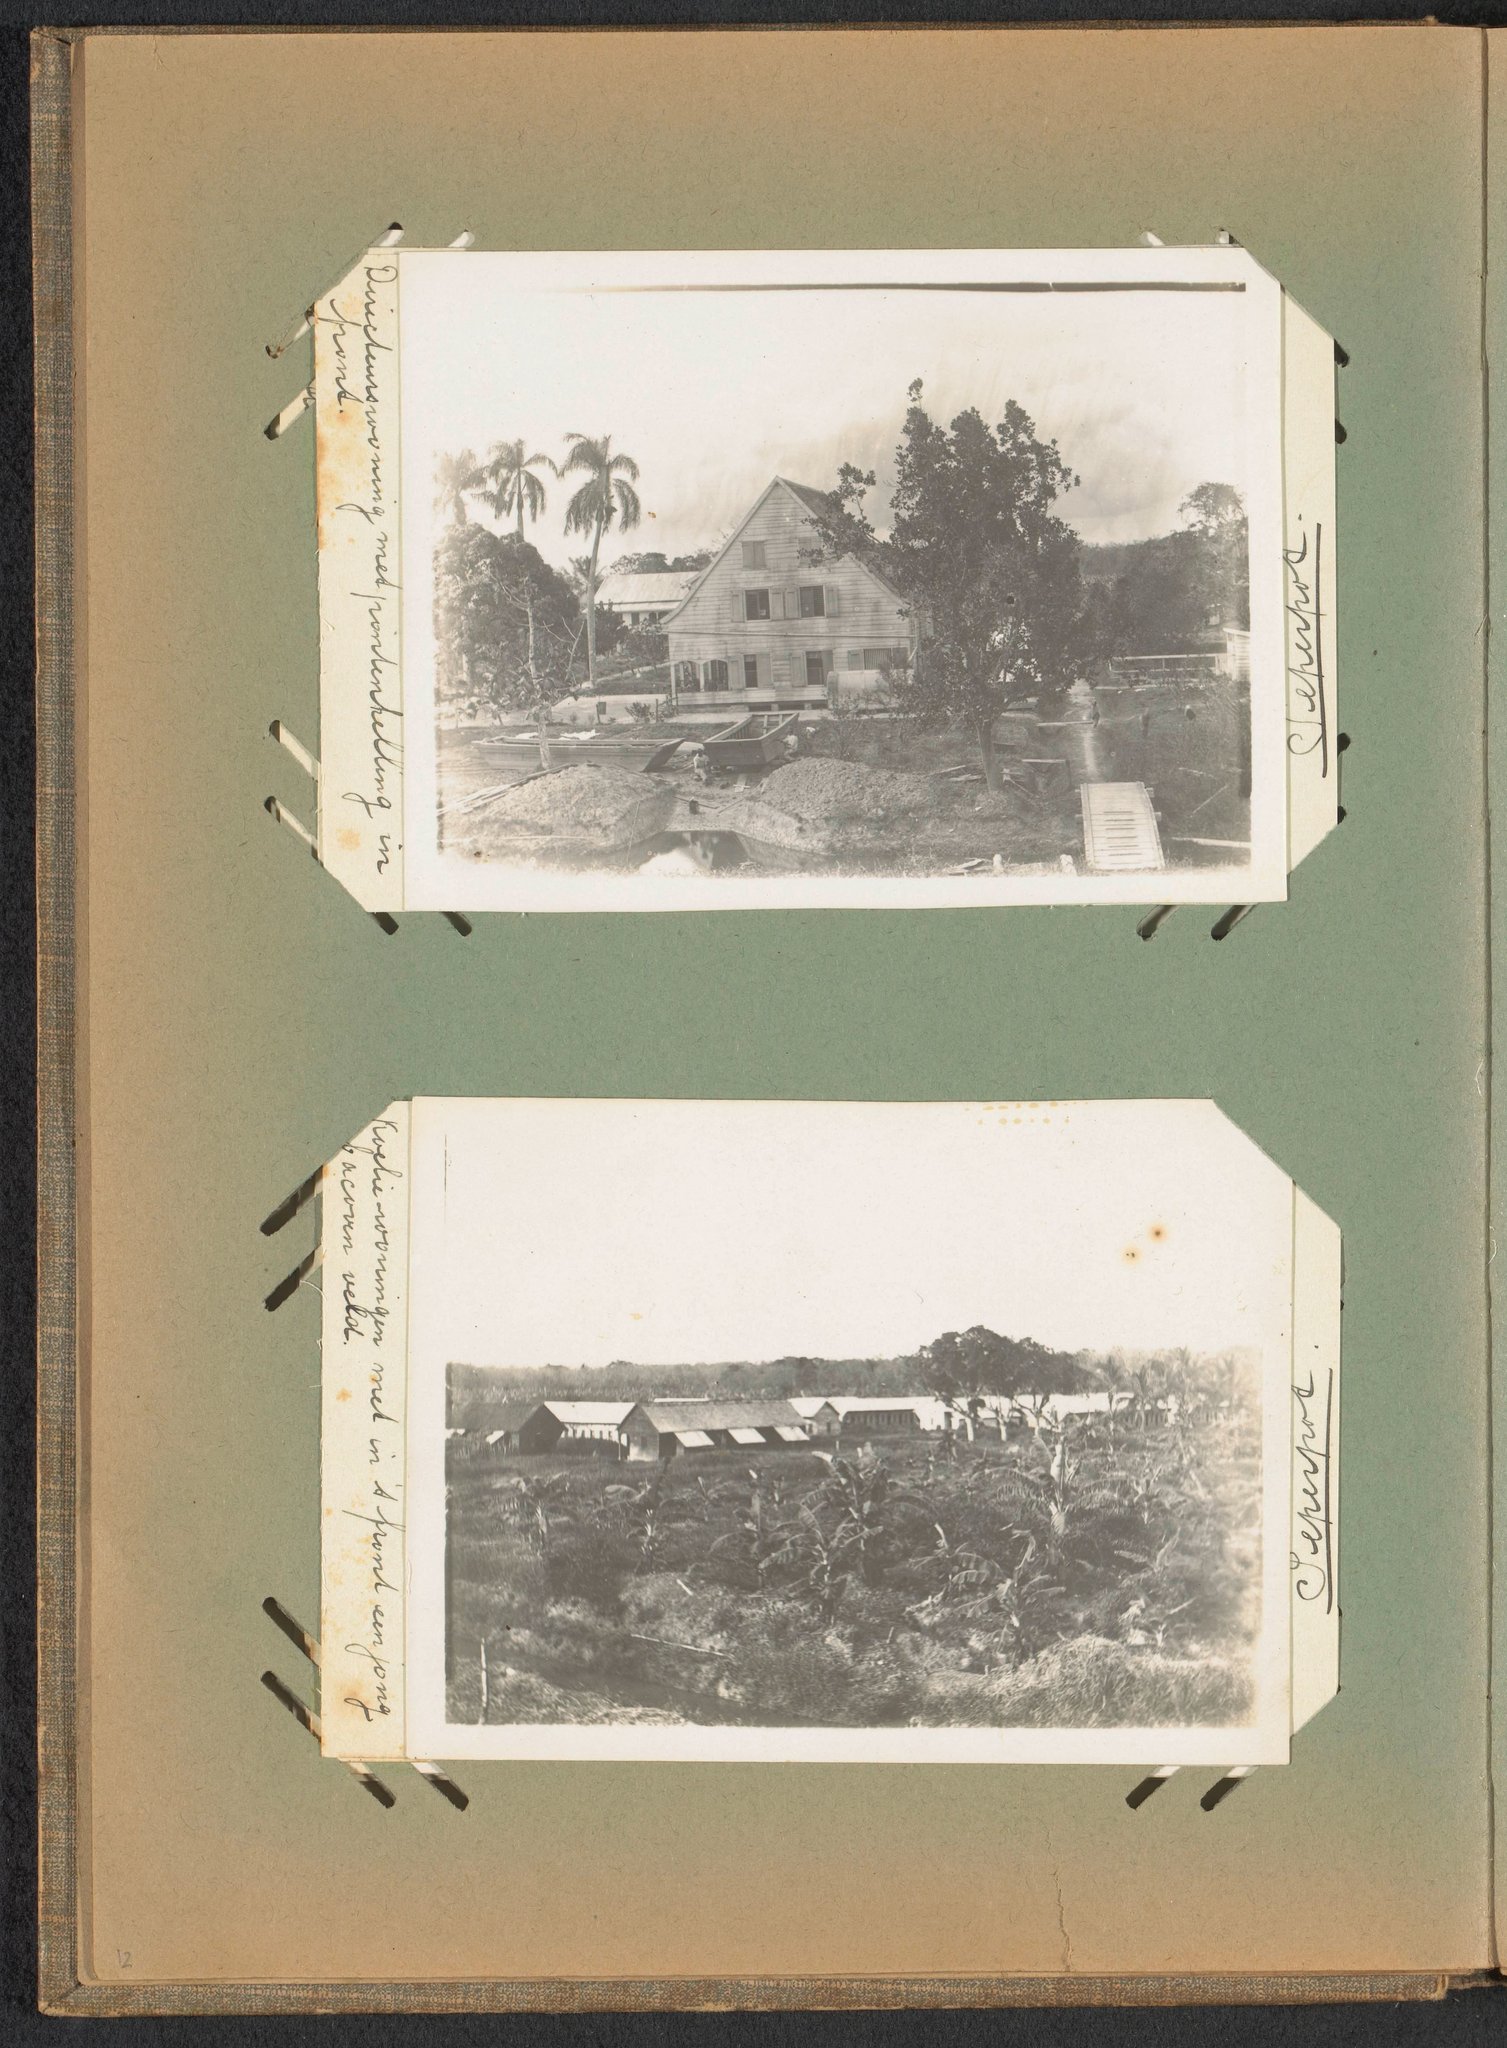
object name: photograph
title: Woningen van contractarbeiders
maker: Anonymous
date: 1912-1913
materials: paper, photographic support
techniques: gelatin silver print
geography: suriname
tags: plantation, fruits: banana, working class, labourers, suriname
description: Behuizing van de contractarbeiders en een bananenveld op Plantage Peperpot in Suriname. Onderdeel van het fotoalbum uit ca. 1912-1913 met 92 foto's van de plantages Peperpot en Dordrecht in Suriname en Mount Pleasant op Curaçao.